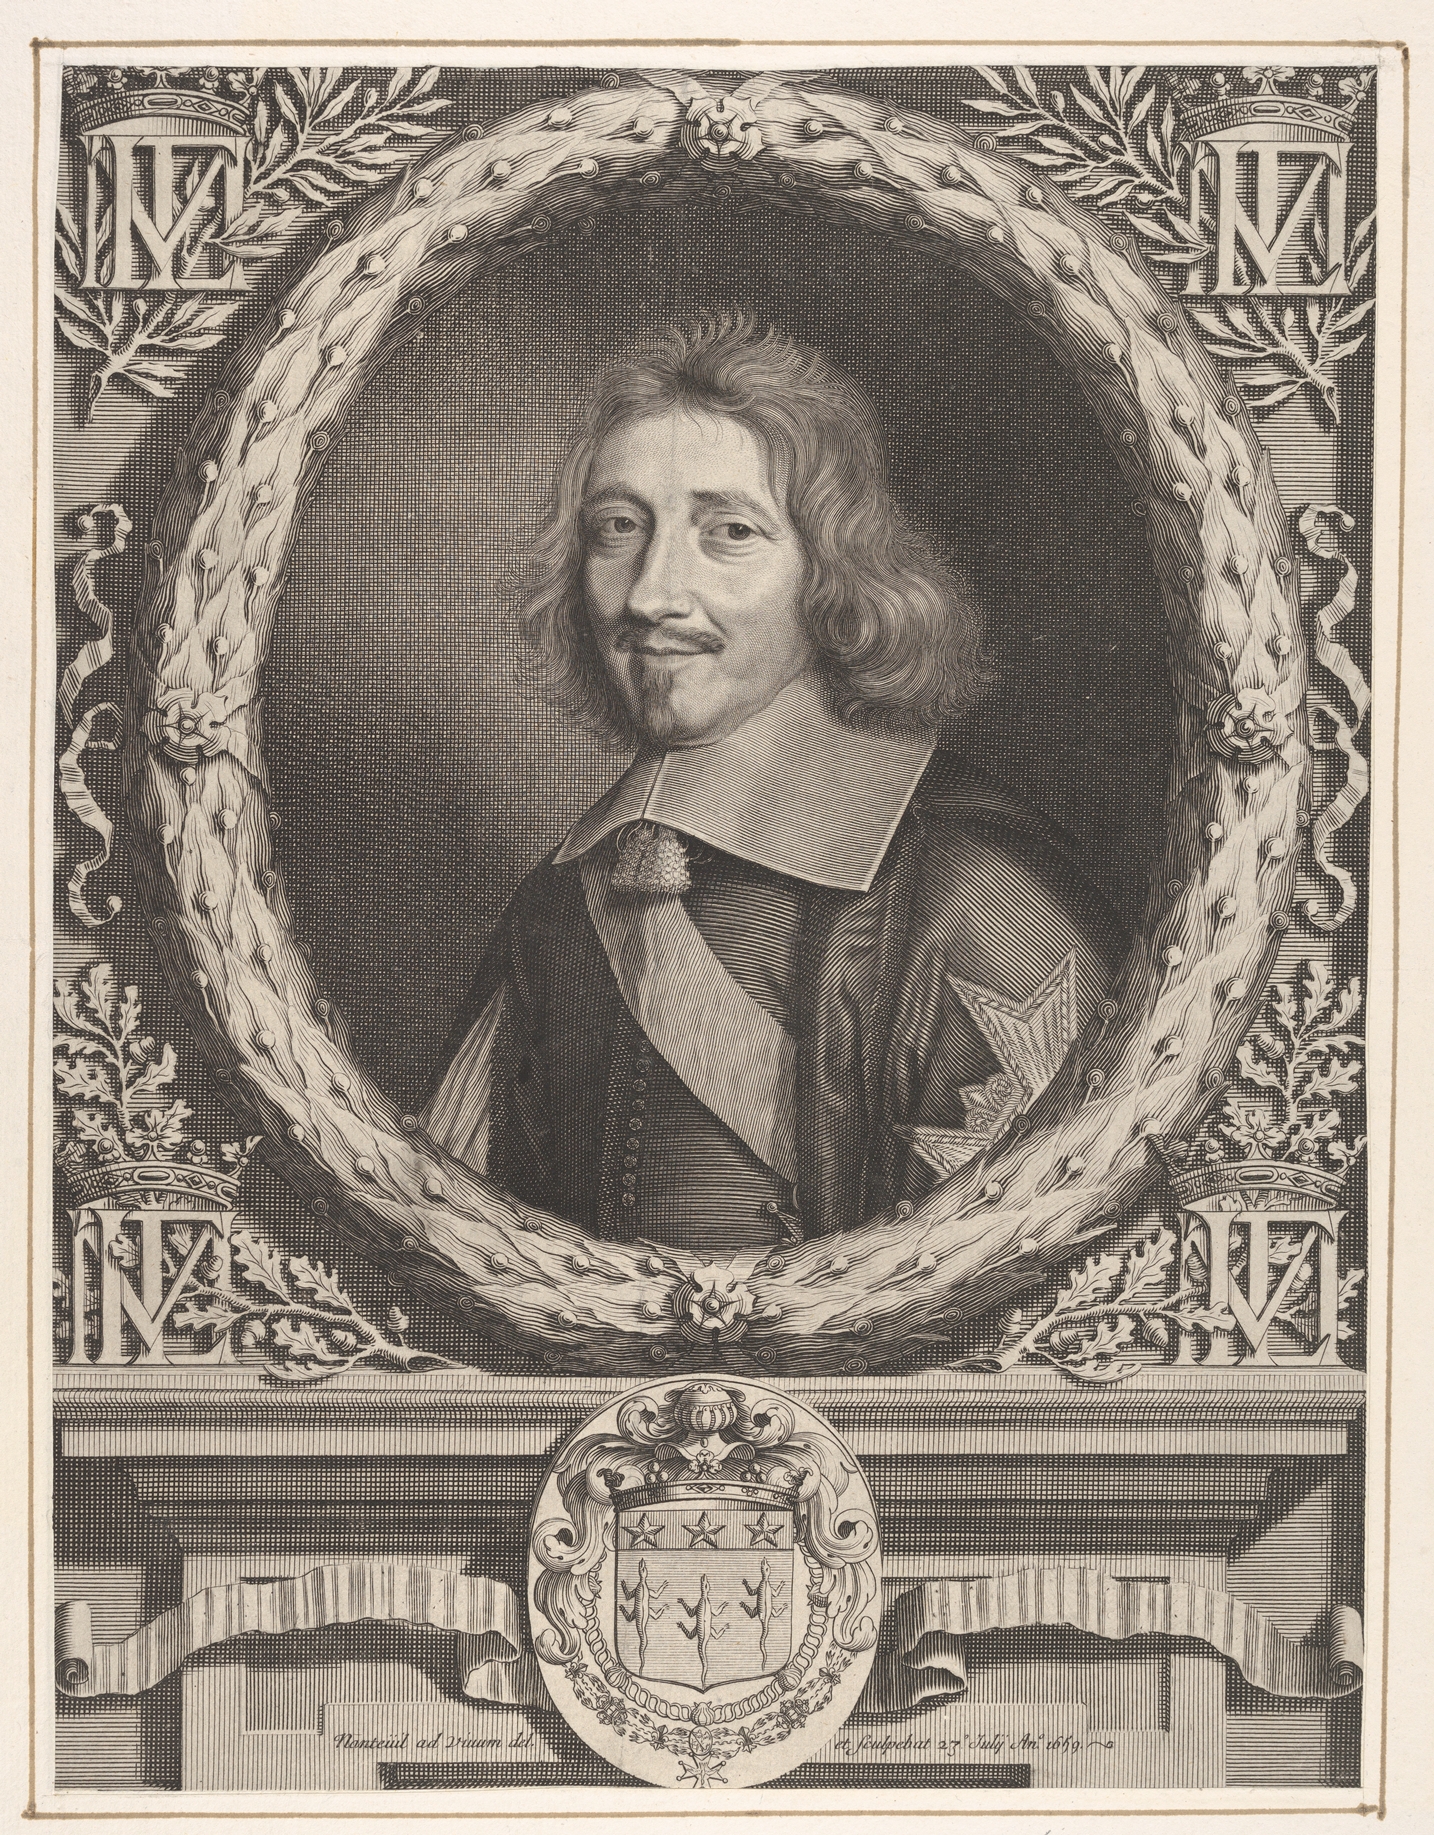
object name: print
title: Chancelier Michel IV Le Tellier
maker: robert nanteuil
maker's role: artist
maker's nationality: french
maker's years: 1623-1678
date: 1659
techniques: engraving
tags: men,portraits,coat of arms